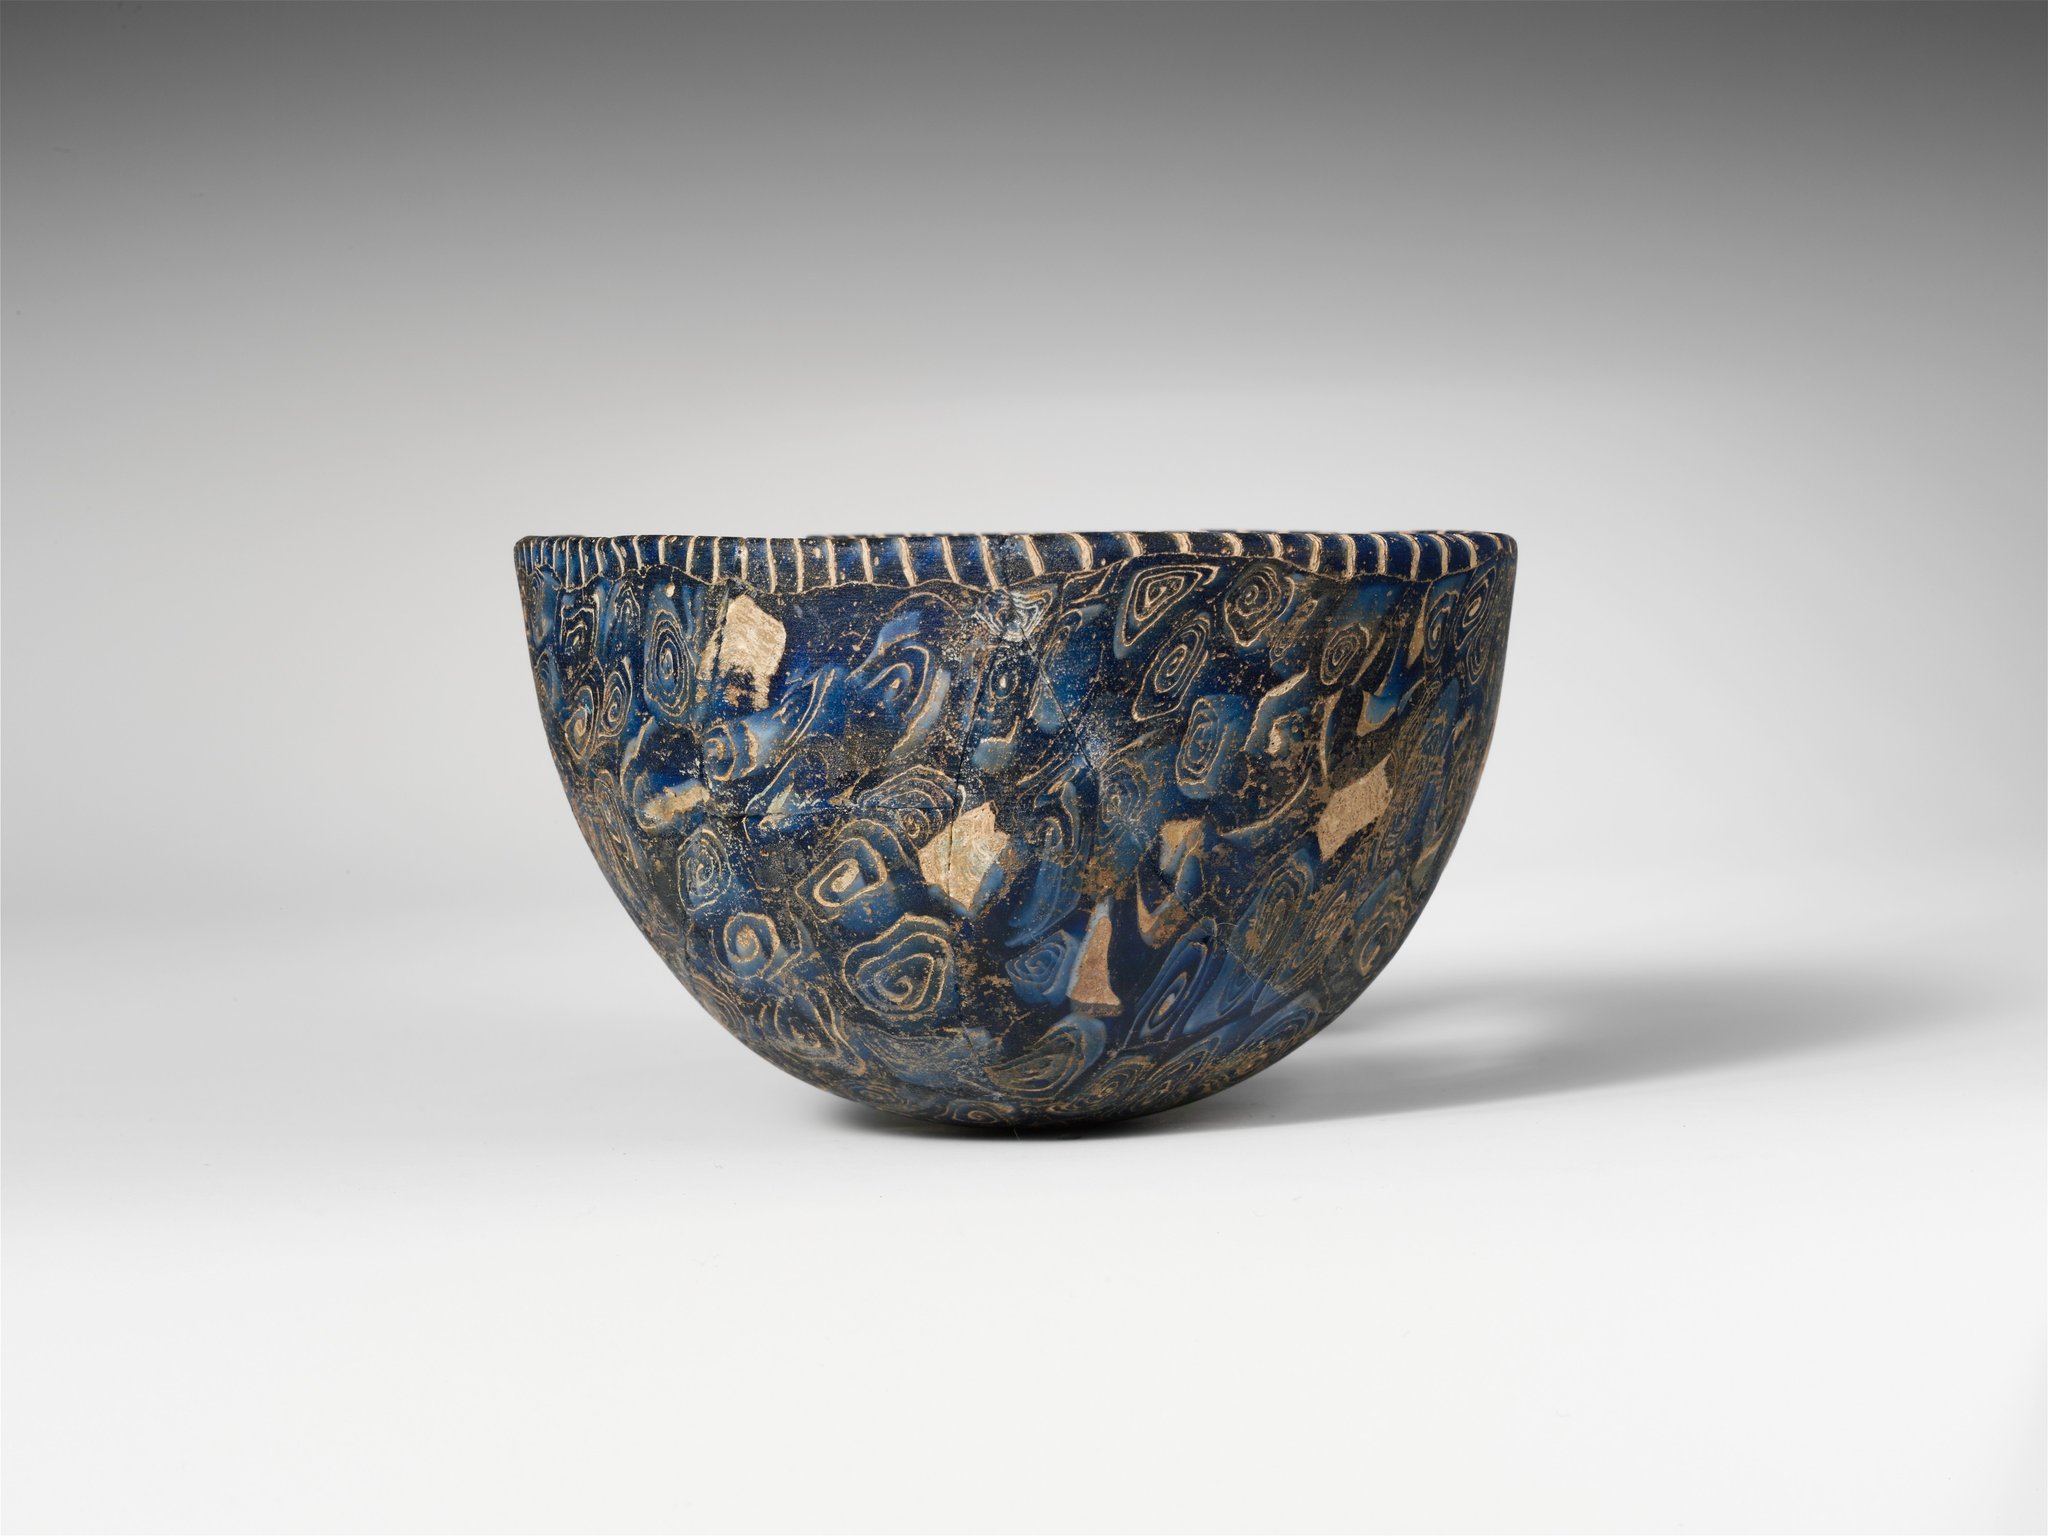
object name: bowl, mosaic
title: Glass mosaic hemispherical bowl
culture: greek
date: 200-35 BCE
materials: glass